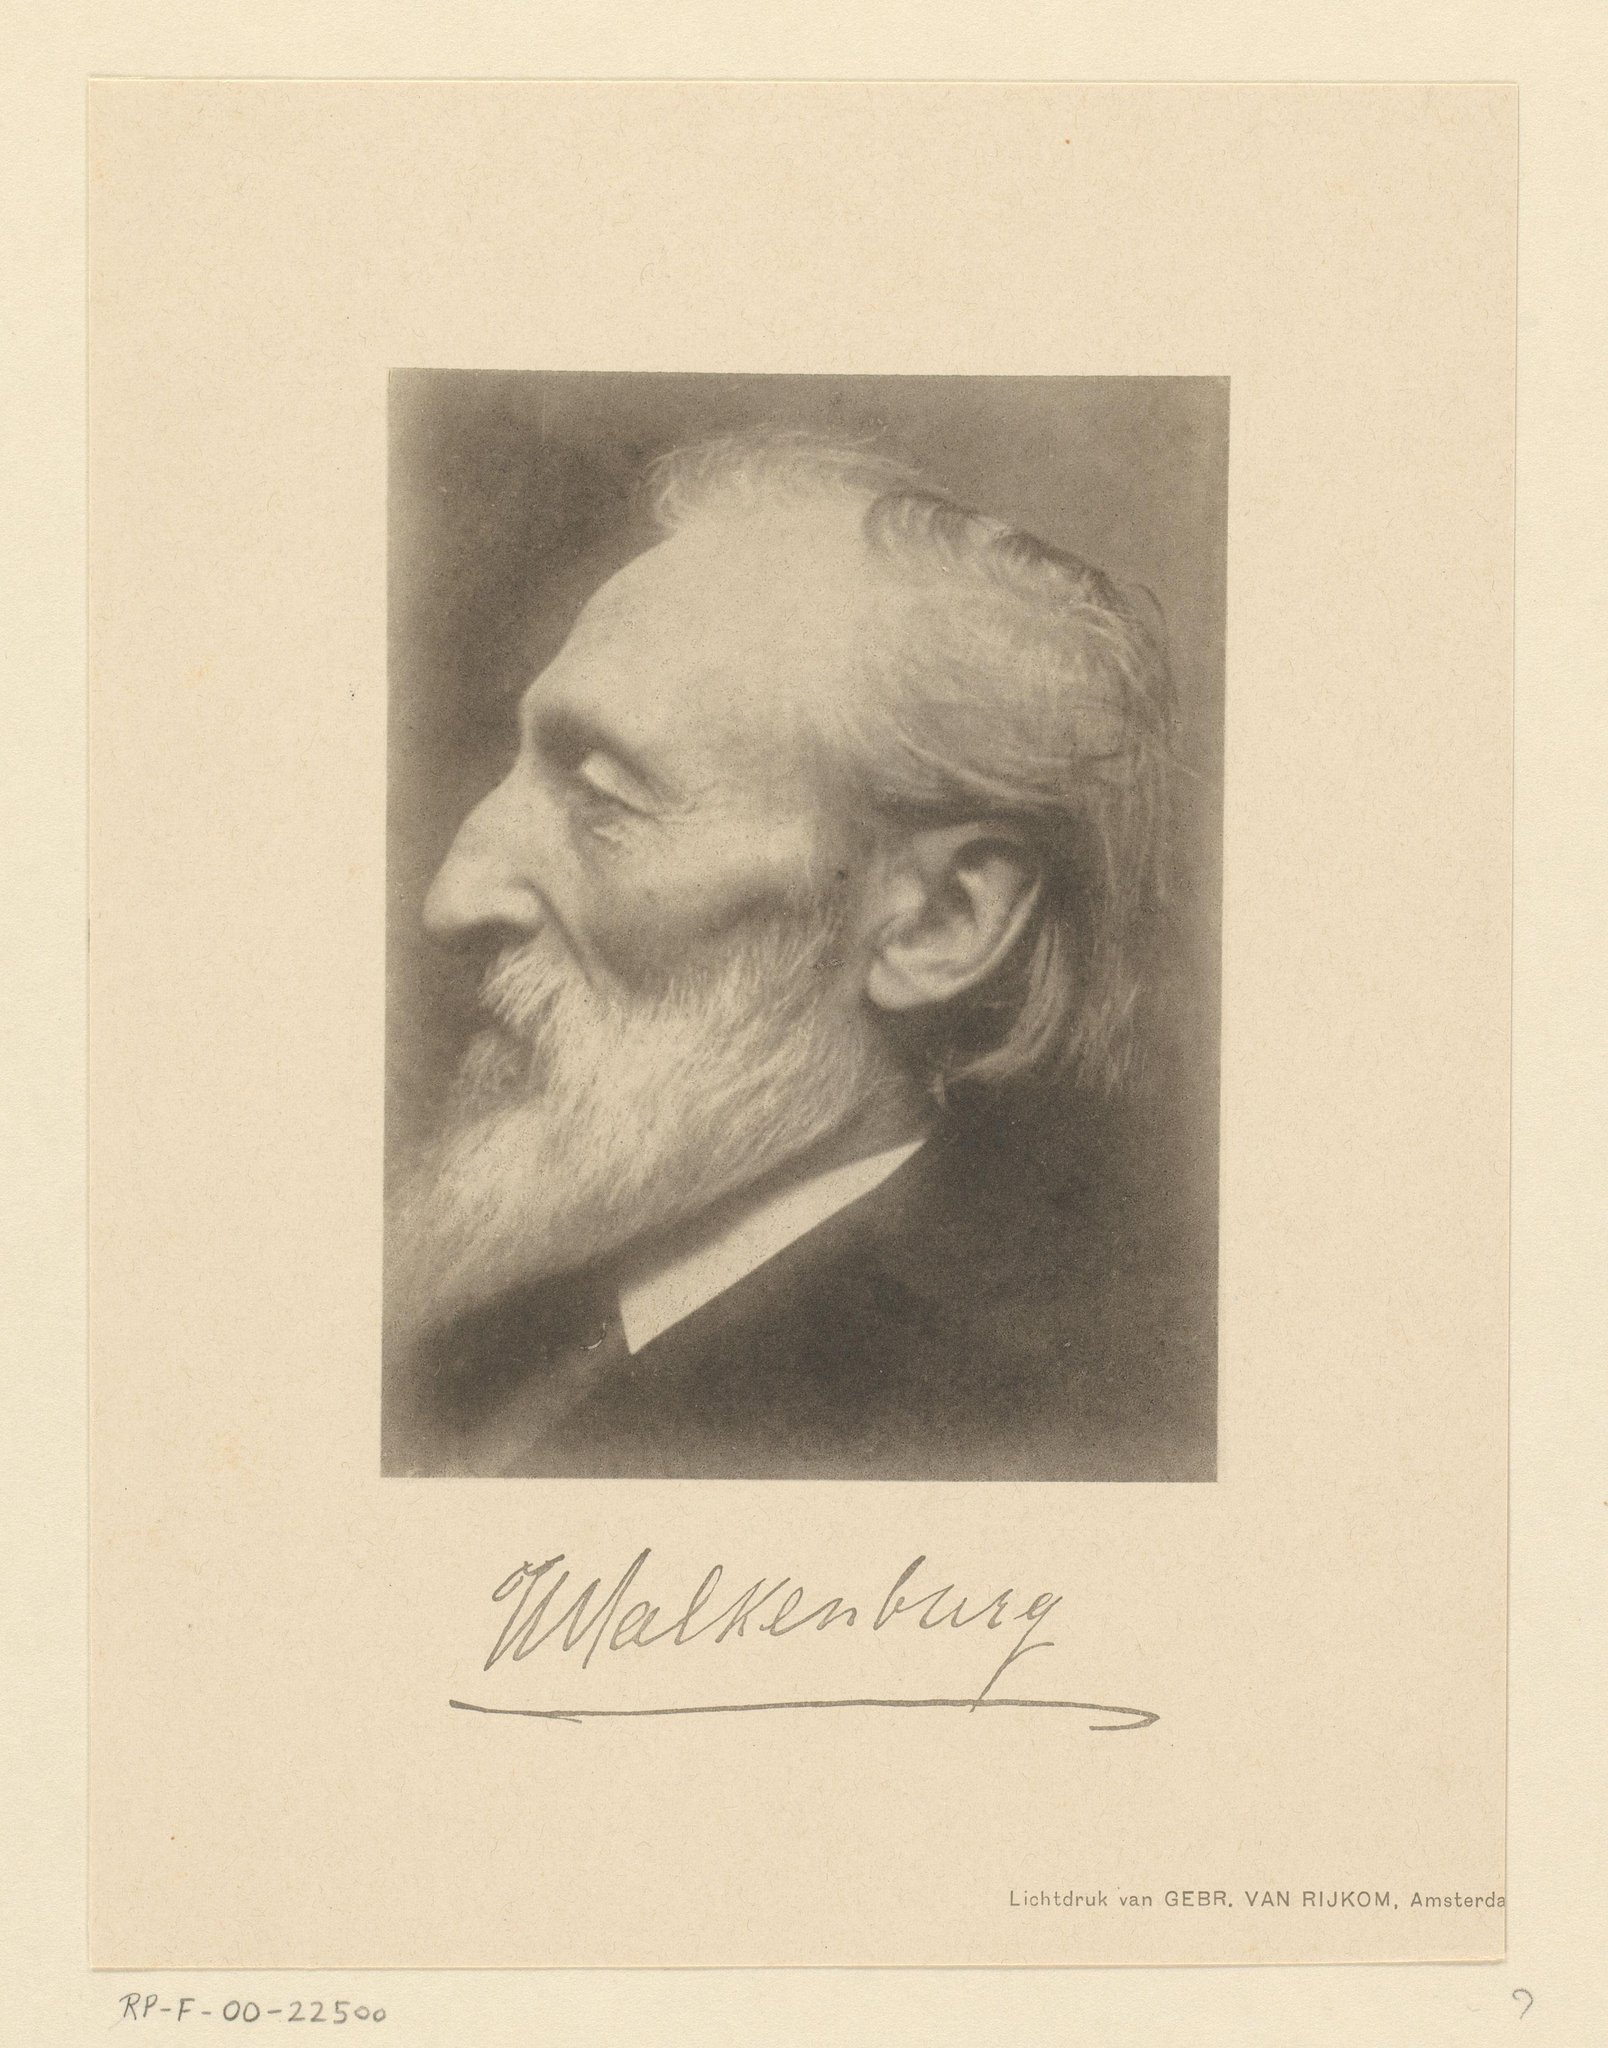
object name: photomechanical print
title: Portret van Hendrik Valkenburg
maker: Anonymous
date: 1890-1896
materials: paper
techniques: photograph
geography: amsterdam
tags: amsterdam, painter, draughtsman, historical persons, old man, portrait, self-portrait of painter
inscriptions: signature: ‘H Valkenburg’